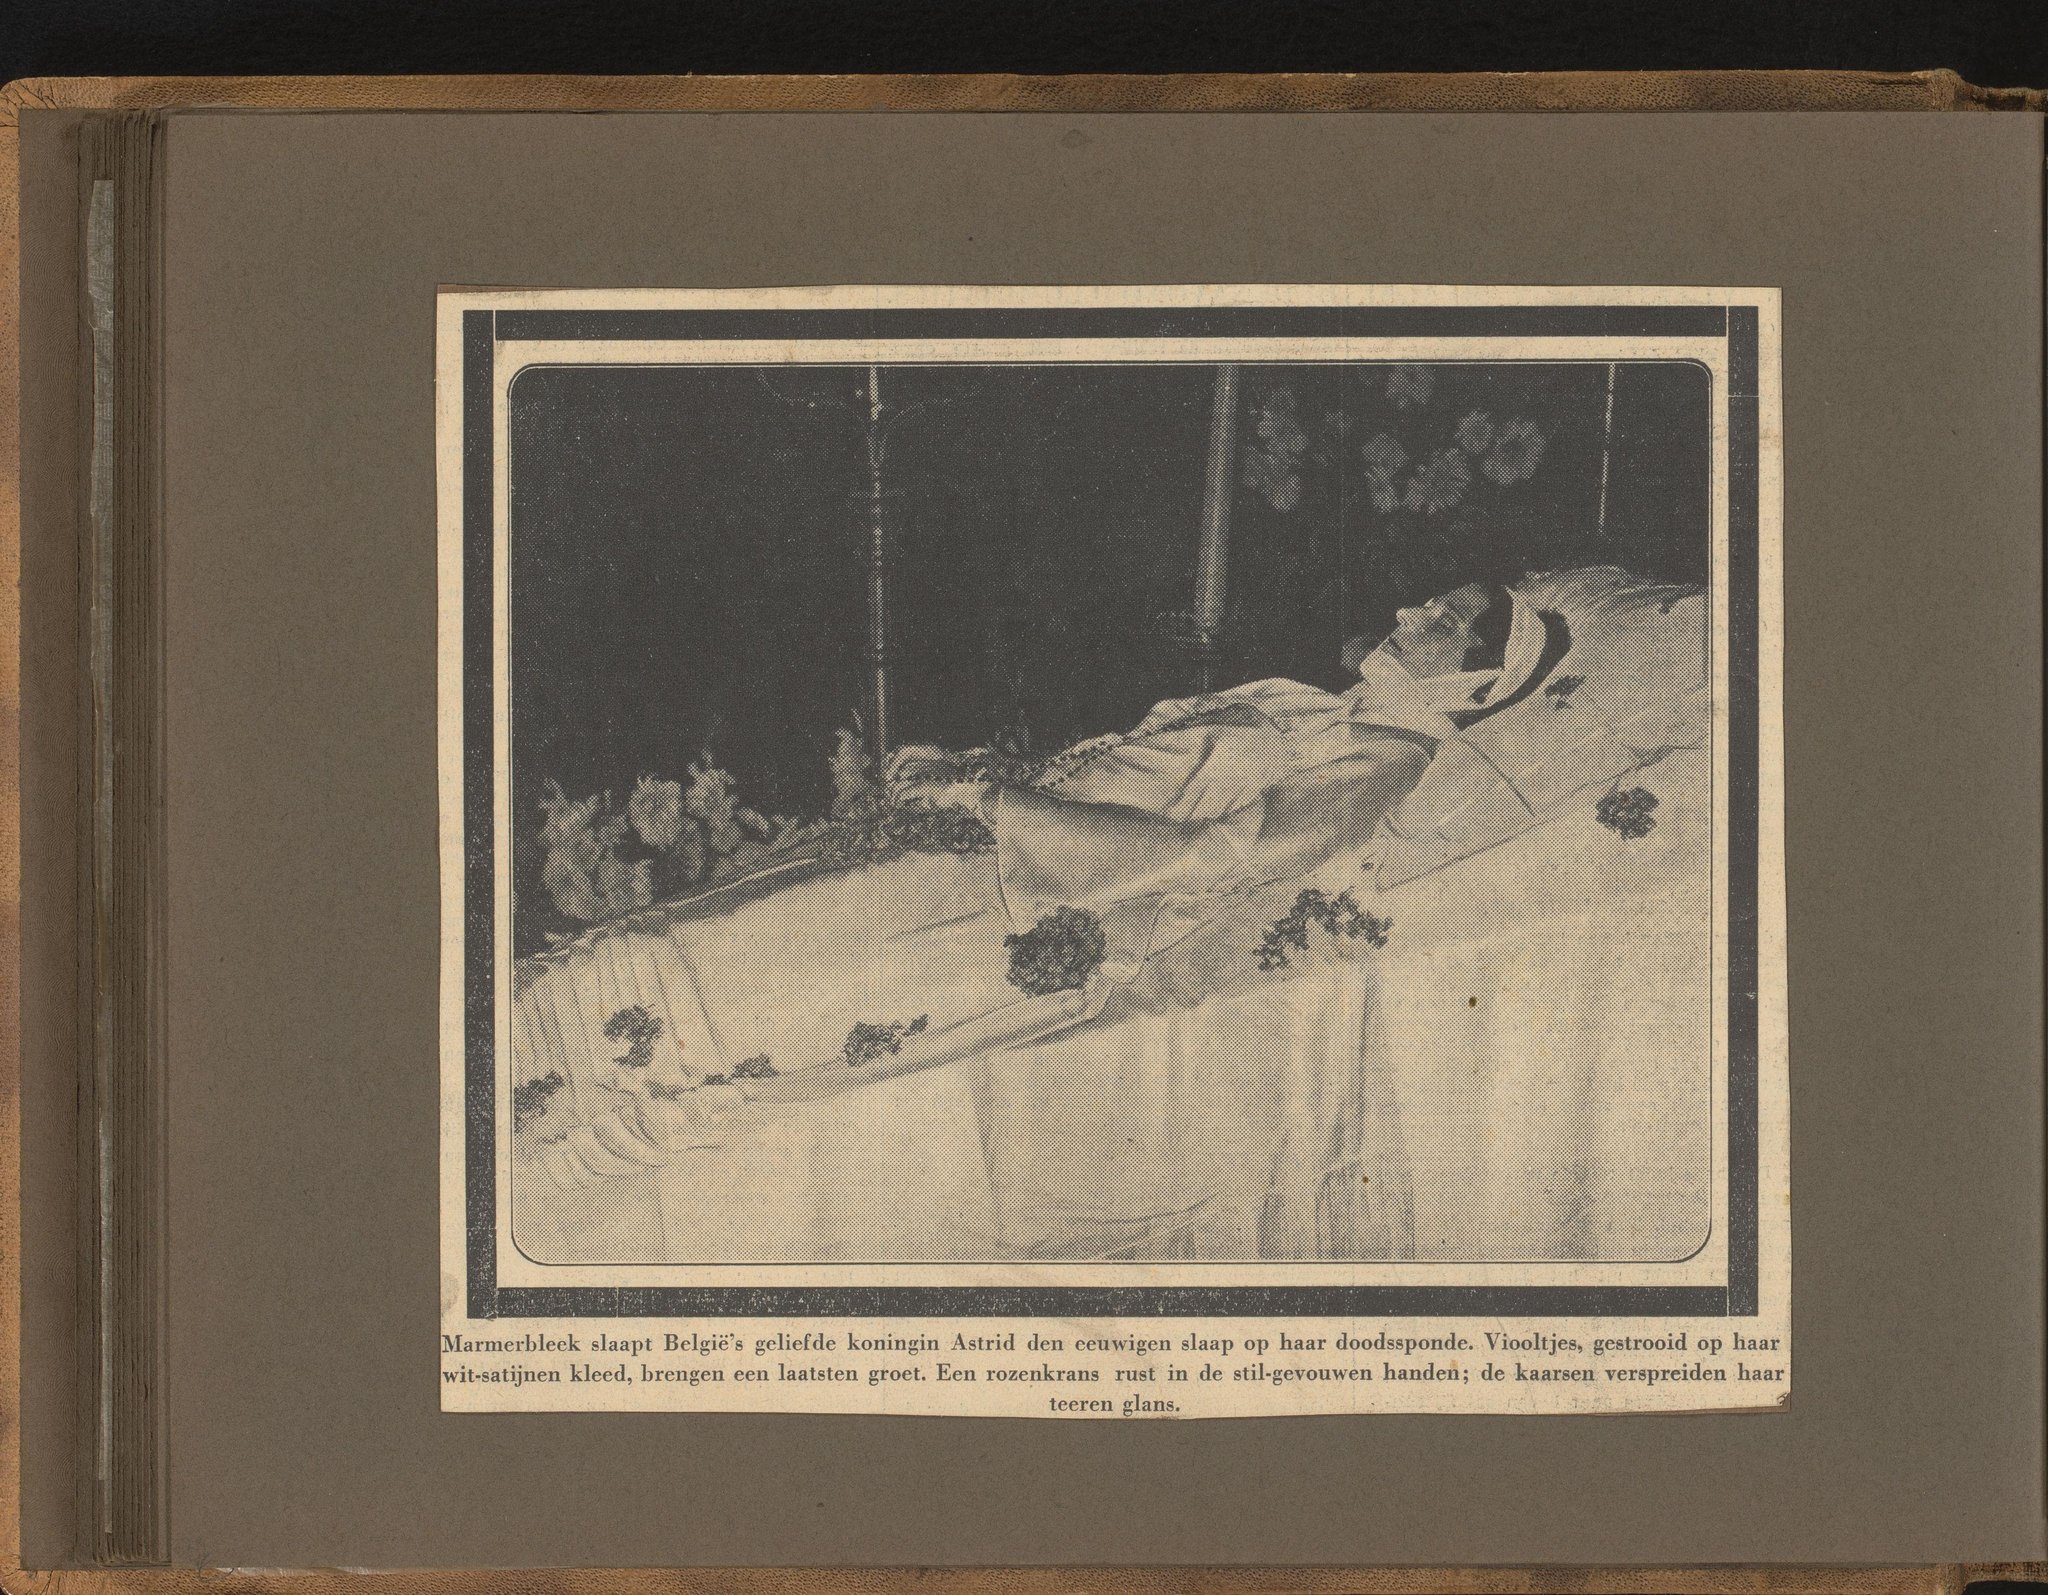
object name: album leaf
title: Post-mortemportret van koningin Astrid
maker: Anonymous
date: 1900-1950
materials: paper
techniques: autotype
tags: adult woman, lying in state, death of human being, brussels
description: Krantenknipsel met de foto van de opgebaarde koningin Astrid. Deze pagina maakt deel uit van een album.